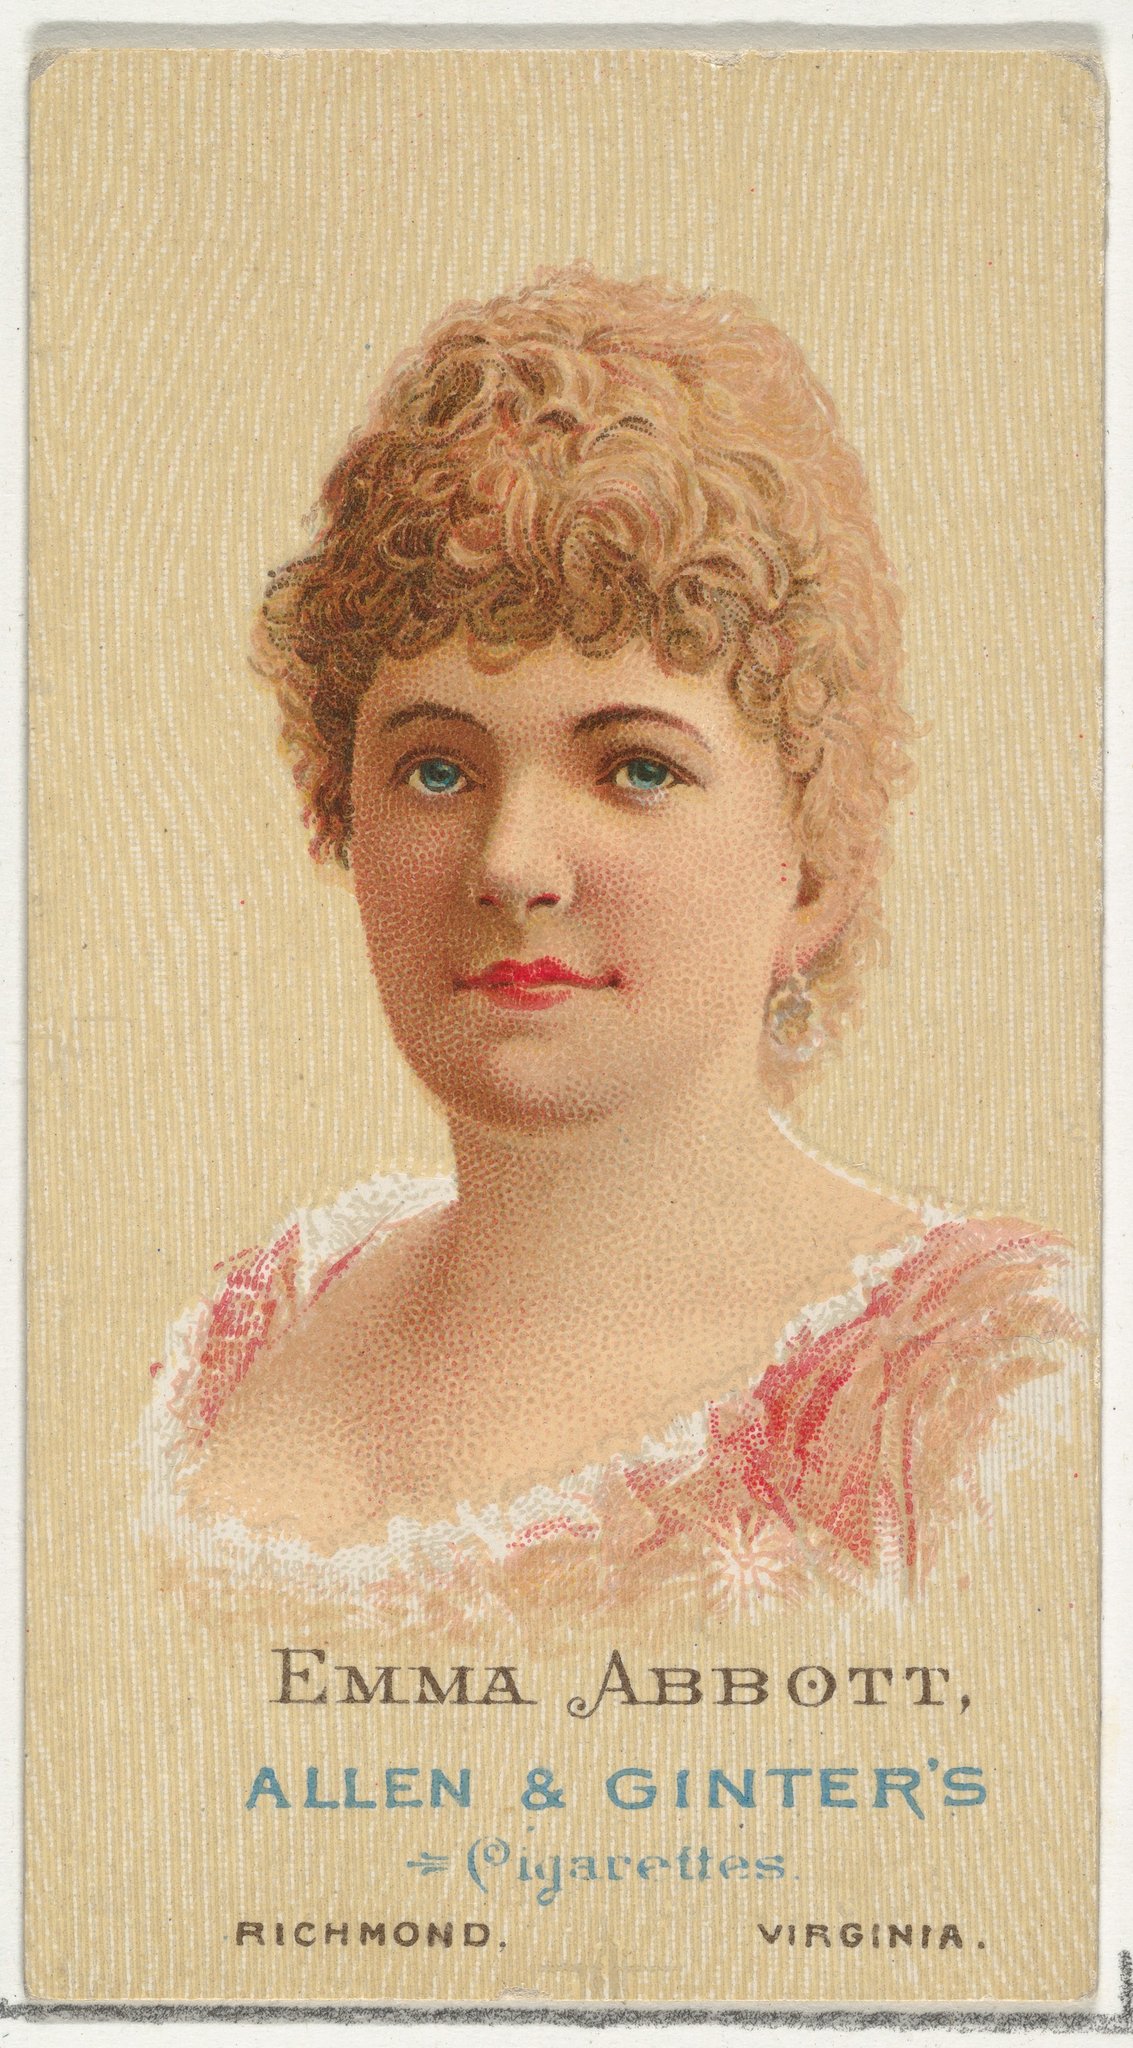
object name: print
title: Emma Abbott, from World's Beauties, Series 2 (N27) for Allen & Ginter Cigarettes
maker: allen & ginter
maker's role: publisher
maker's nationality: american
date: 1888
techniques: color lithograph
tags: women